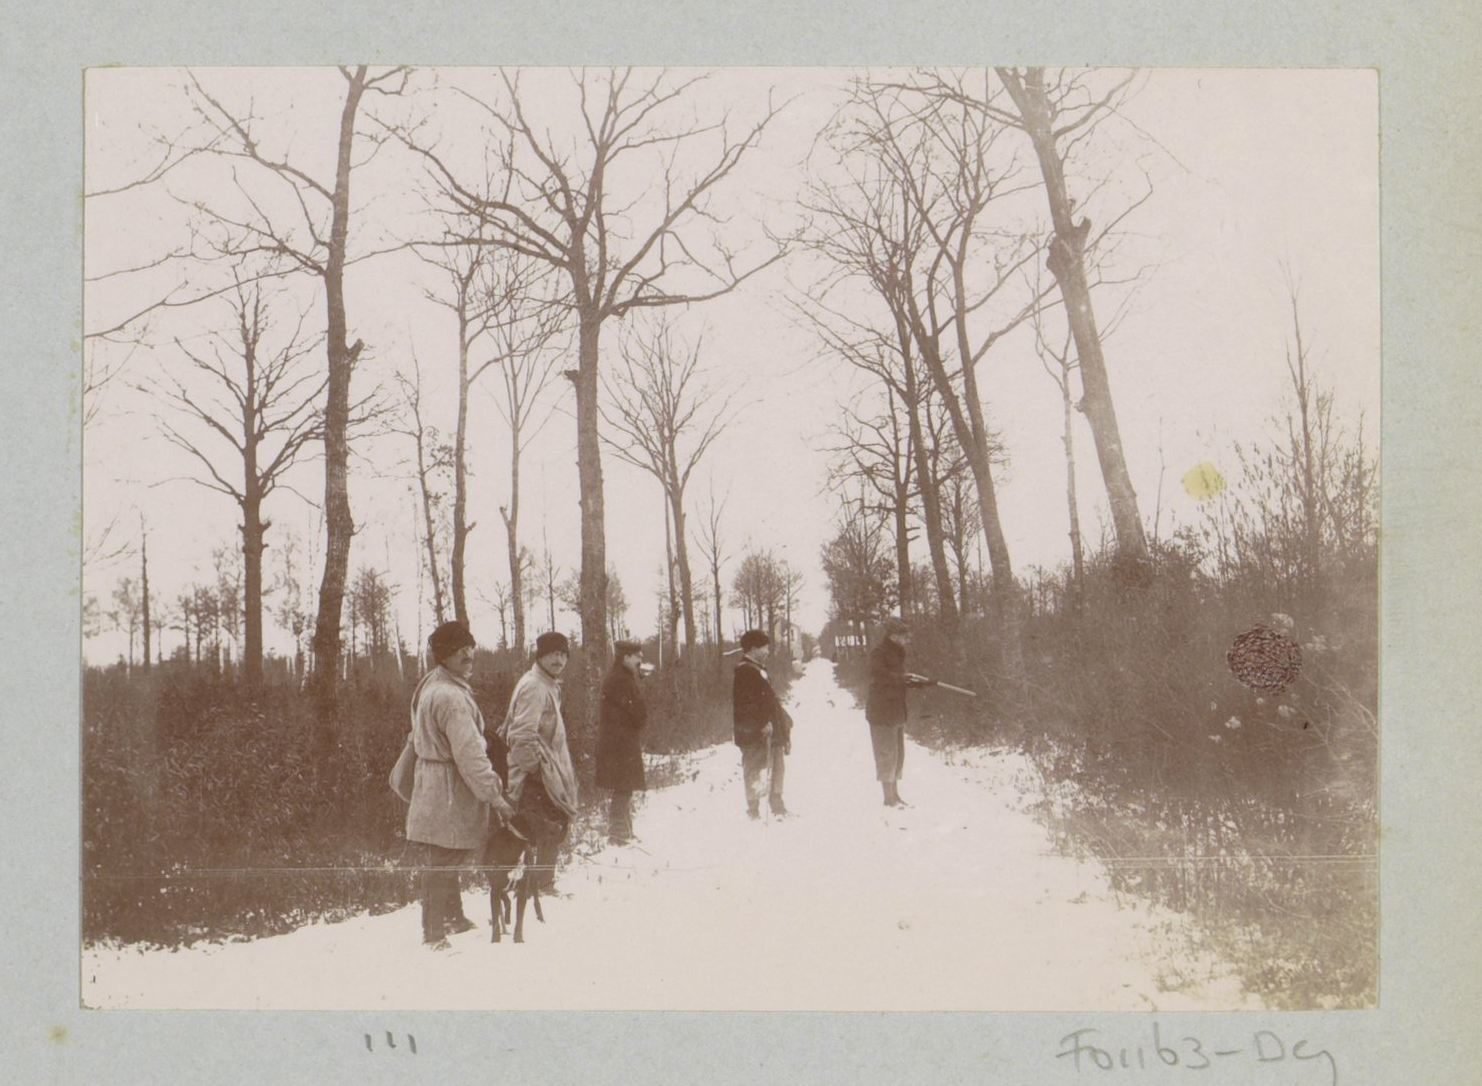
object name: photograph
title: Groep jagers met hond op besneeuwd pad, vermoedelijk bij Arcachon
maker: delizy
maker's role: manufacturer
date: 1897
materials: paper, photographic support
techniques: gelatin silver print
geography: arcachon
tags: hunting dogs, hunter, forest path or lane, snow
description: Onderdeel van Fotoalbum van een Franse amateurfotograaf met opnames van uitstapjes in Frankrijk, Spanje, België, Luxemburg en Nederland, de eerste automobielen en autoraces.